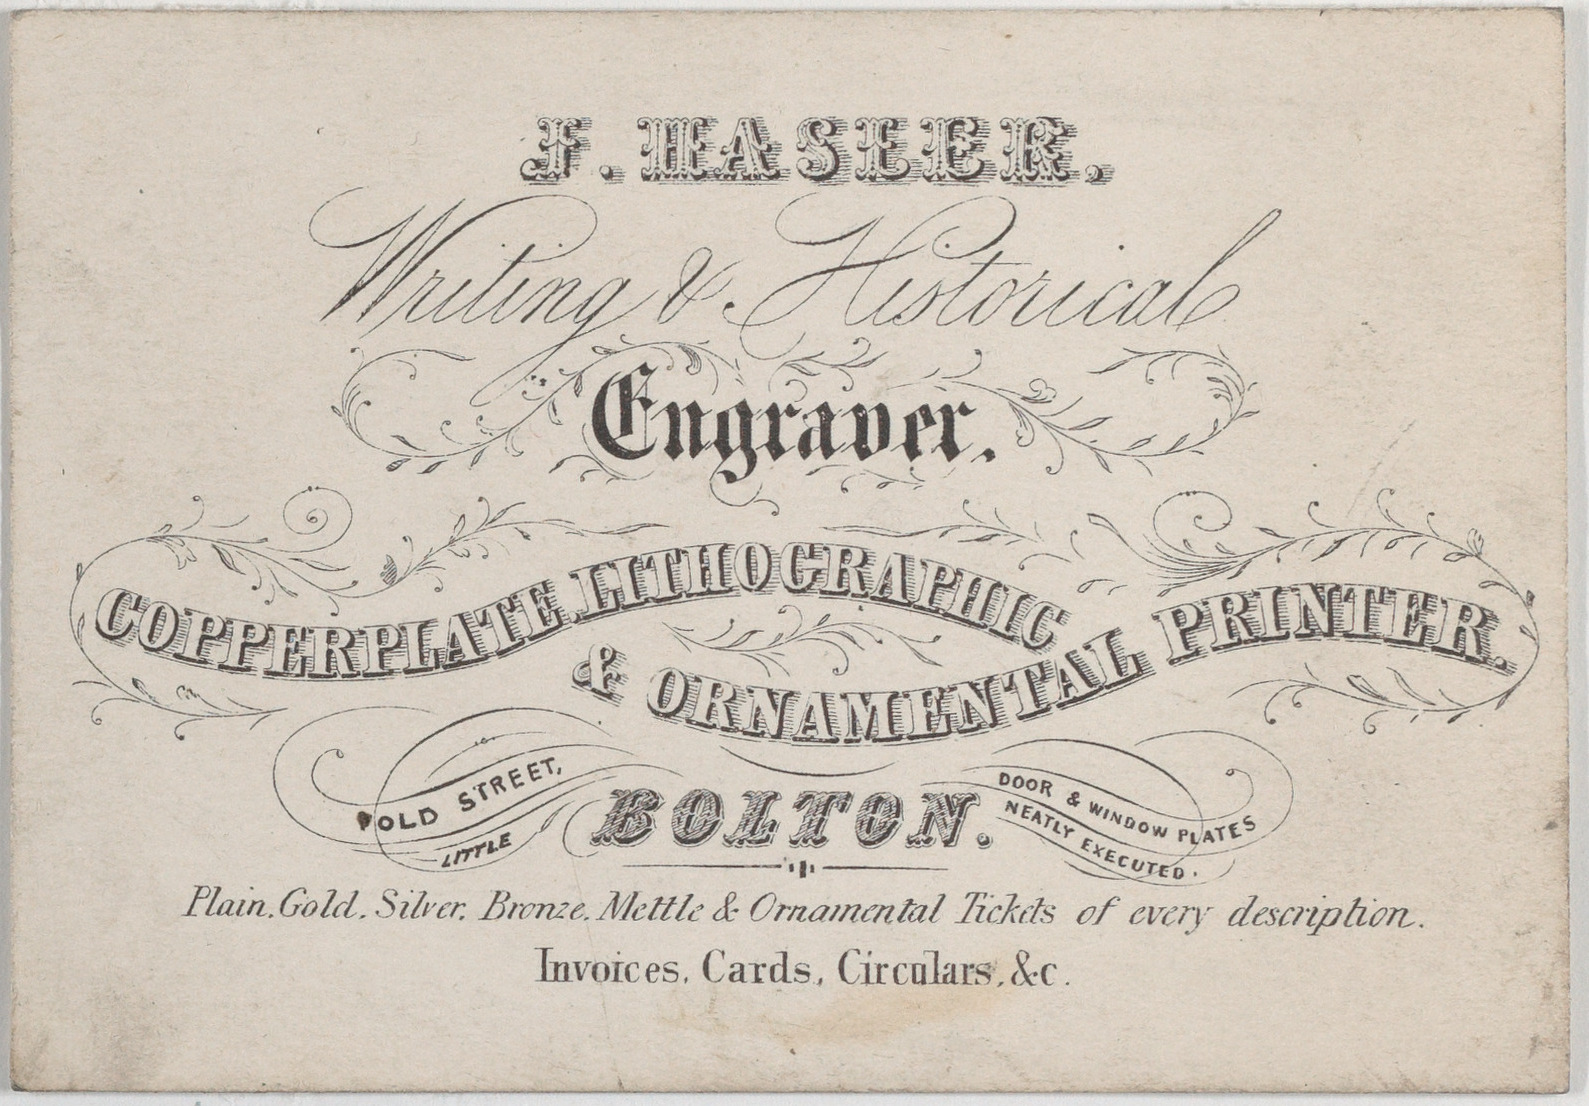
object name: print, trade card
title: Trade Card for J. Hasler, Writing & Historical Engraver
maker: anonymous, british, 19th century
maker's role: artist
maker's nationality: british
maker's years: 1800-1900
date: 1801-1900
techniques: engraving